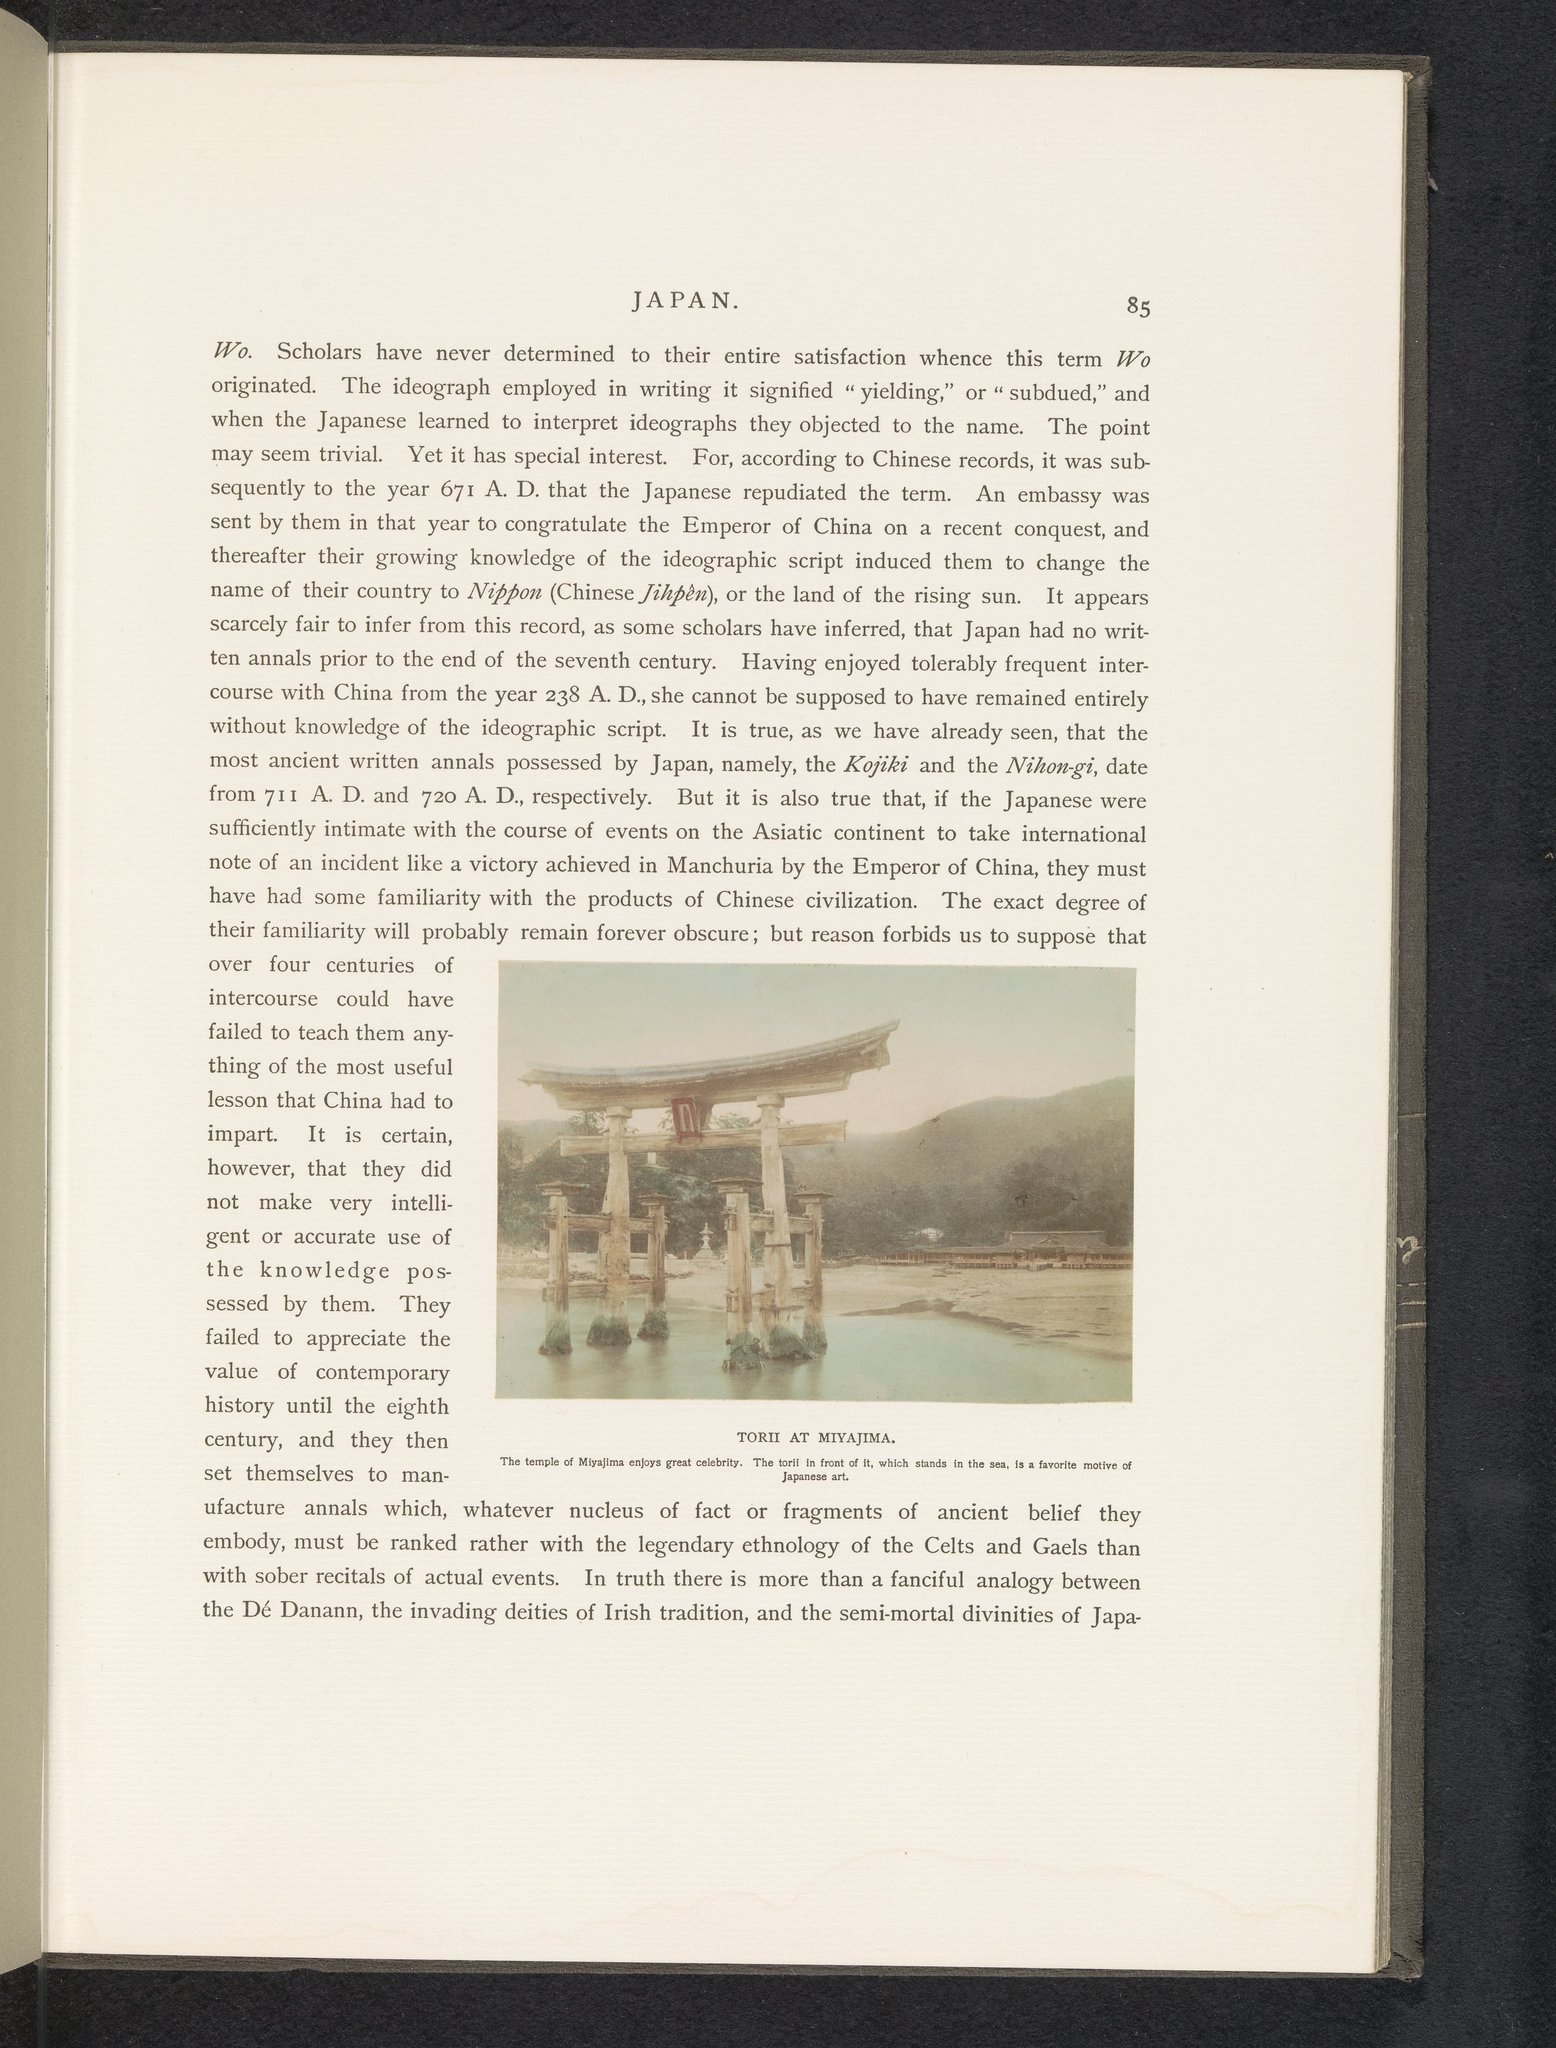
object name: page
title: Torii at Miyjima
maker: Anonymous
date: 1887-1897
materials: photographic support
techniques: albumen print, hand coloring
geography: japan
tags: island, gate, entrance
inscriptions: inscription: ‘The temple of Miyajima enjoys great celebrity. The torii in front of it, which stands in the sea, is a favorite motive of Japanese art.’